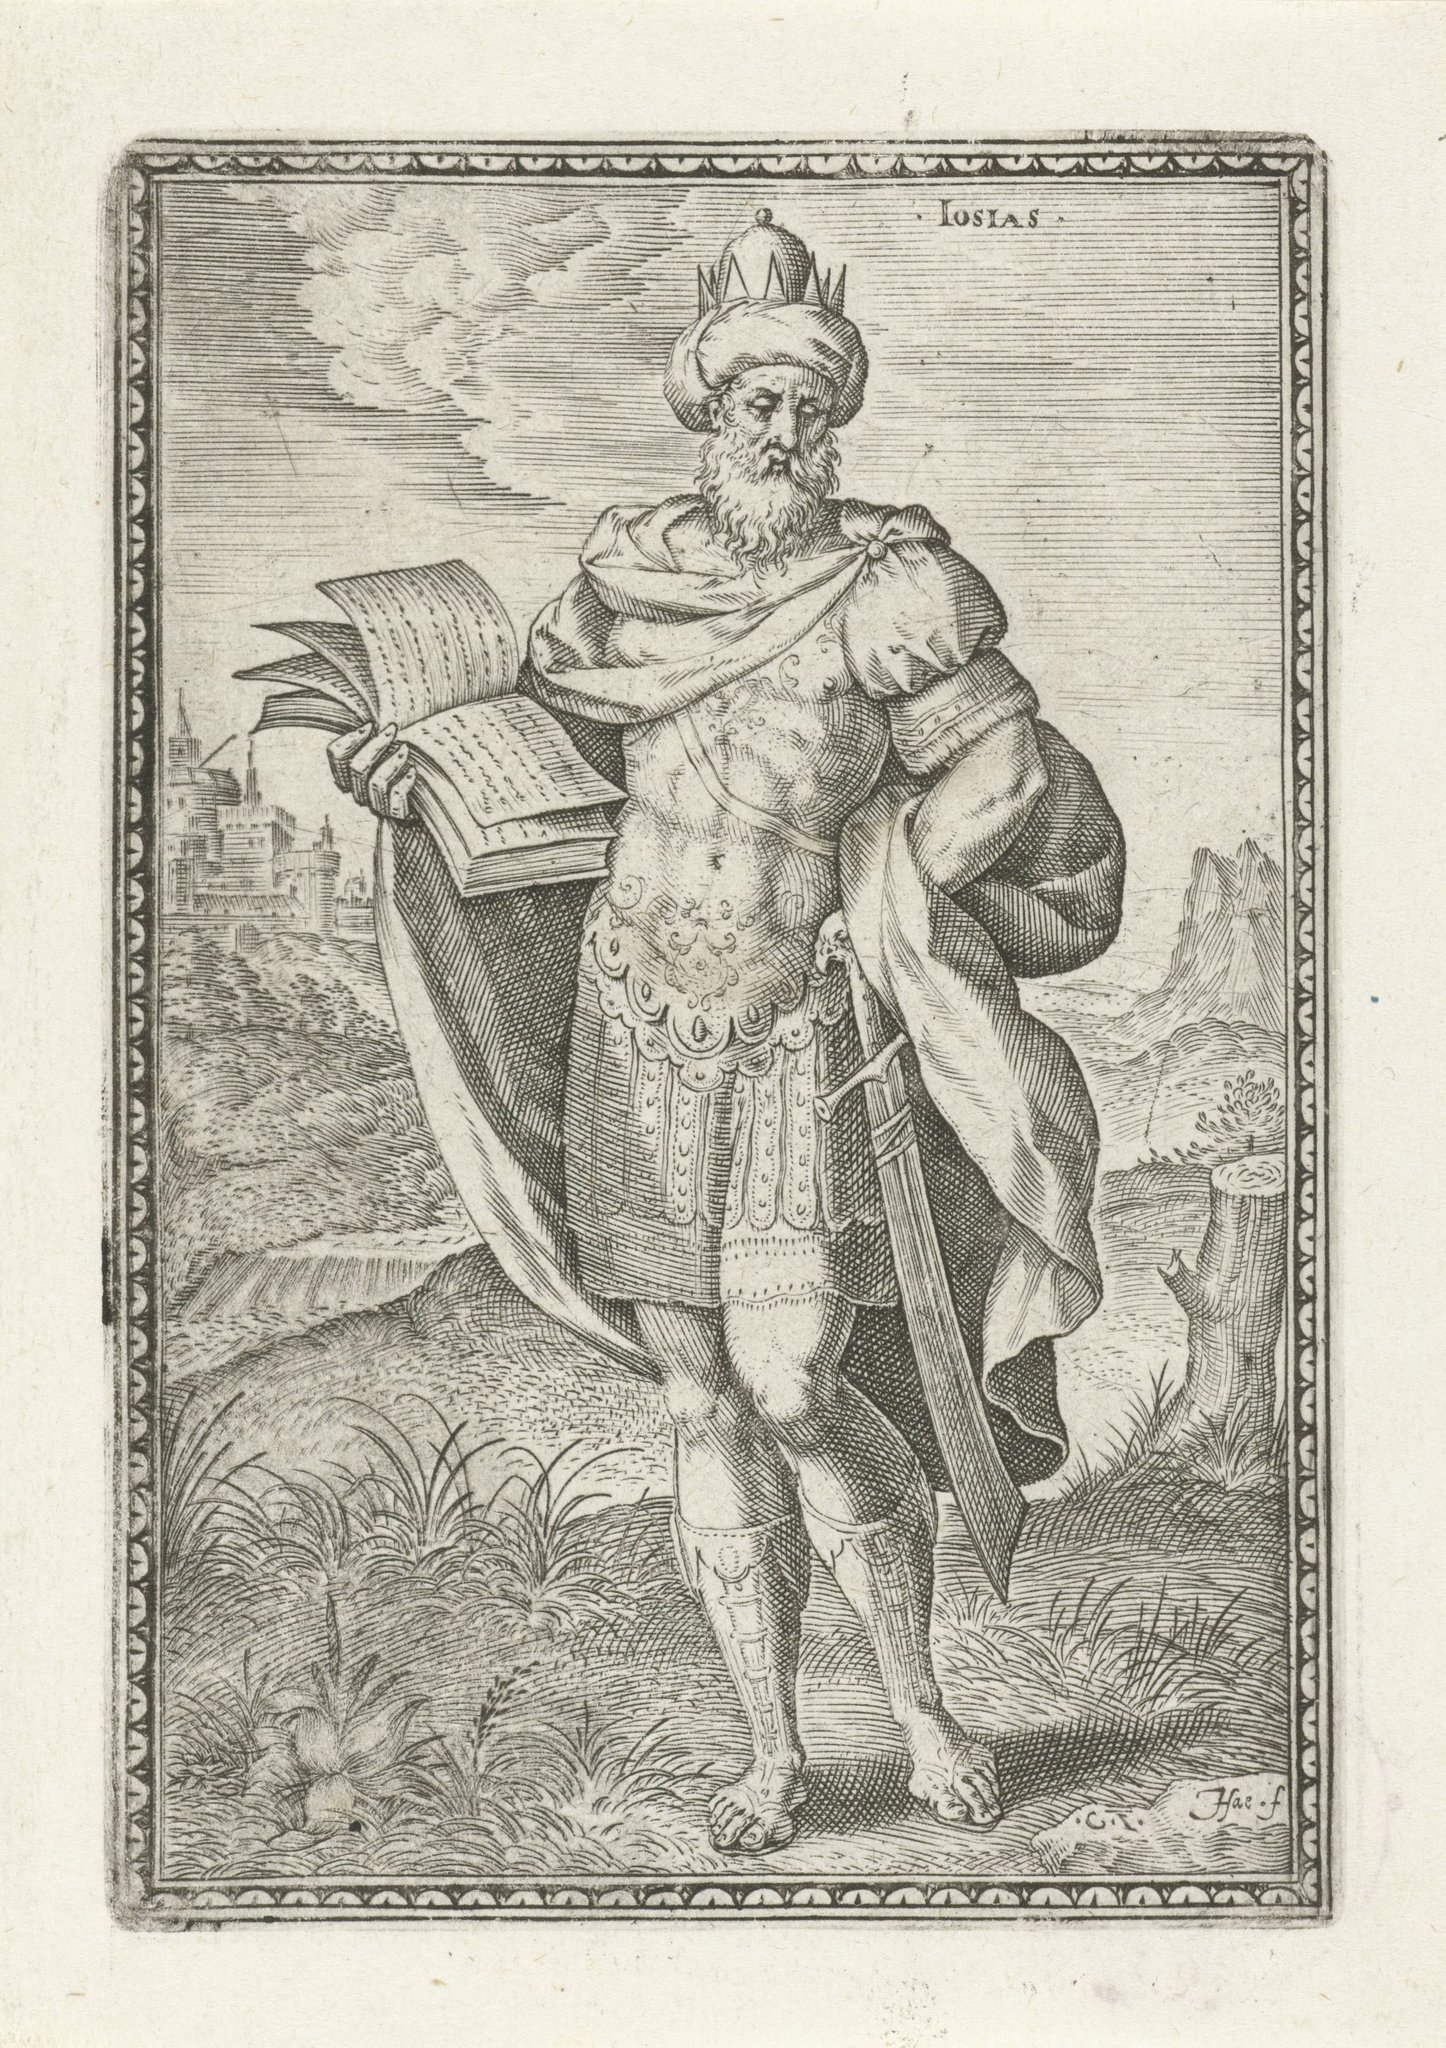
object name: print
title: Josia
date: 1575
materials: paper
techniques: engraving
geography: antwerp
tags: male persons from the old testament (with name) (not in biblical context)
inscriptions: collector's mark: Lugt 240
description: Josia, koning van Juda, in een landschap. Hij houdt een boek vast. De tweeëntwintigste prent van een 39-delige reeks met als onderwerp personen uit het Oude Testament.